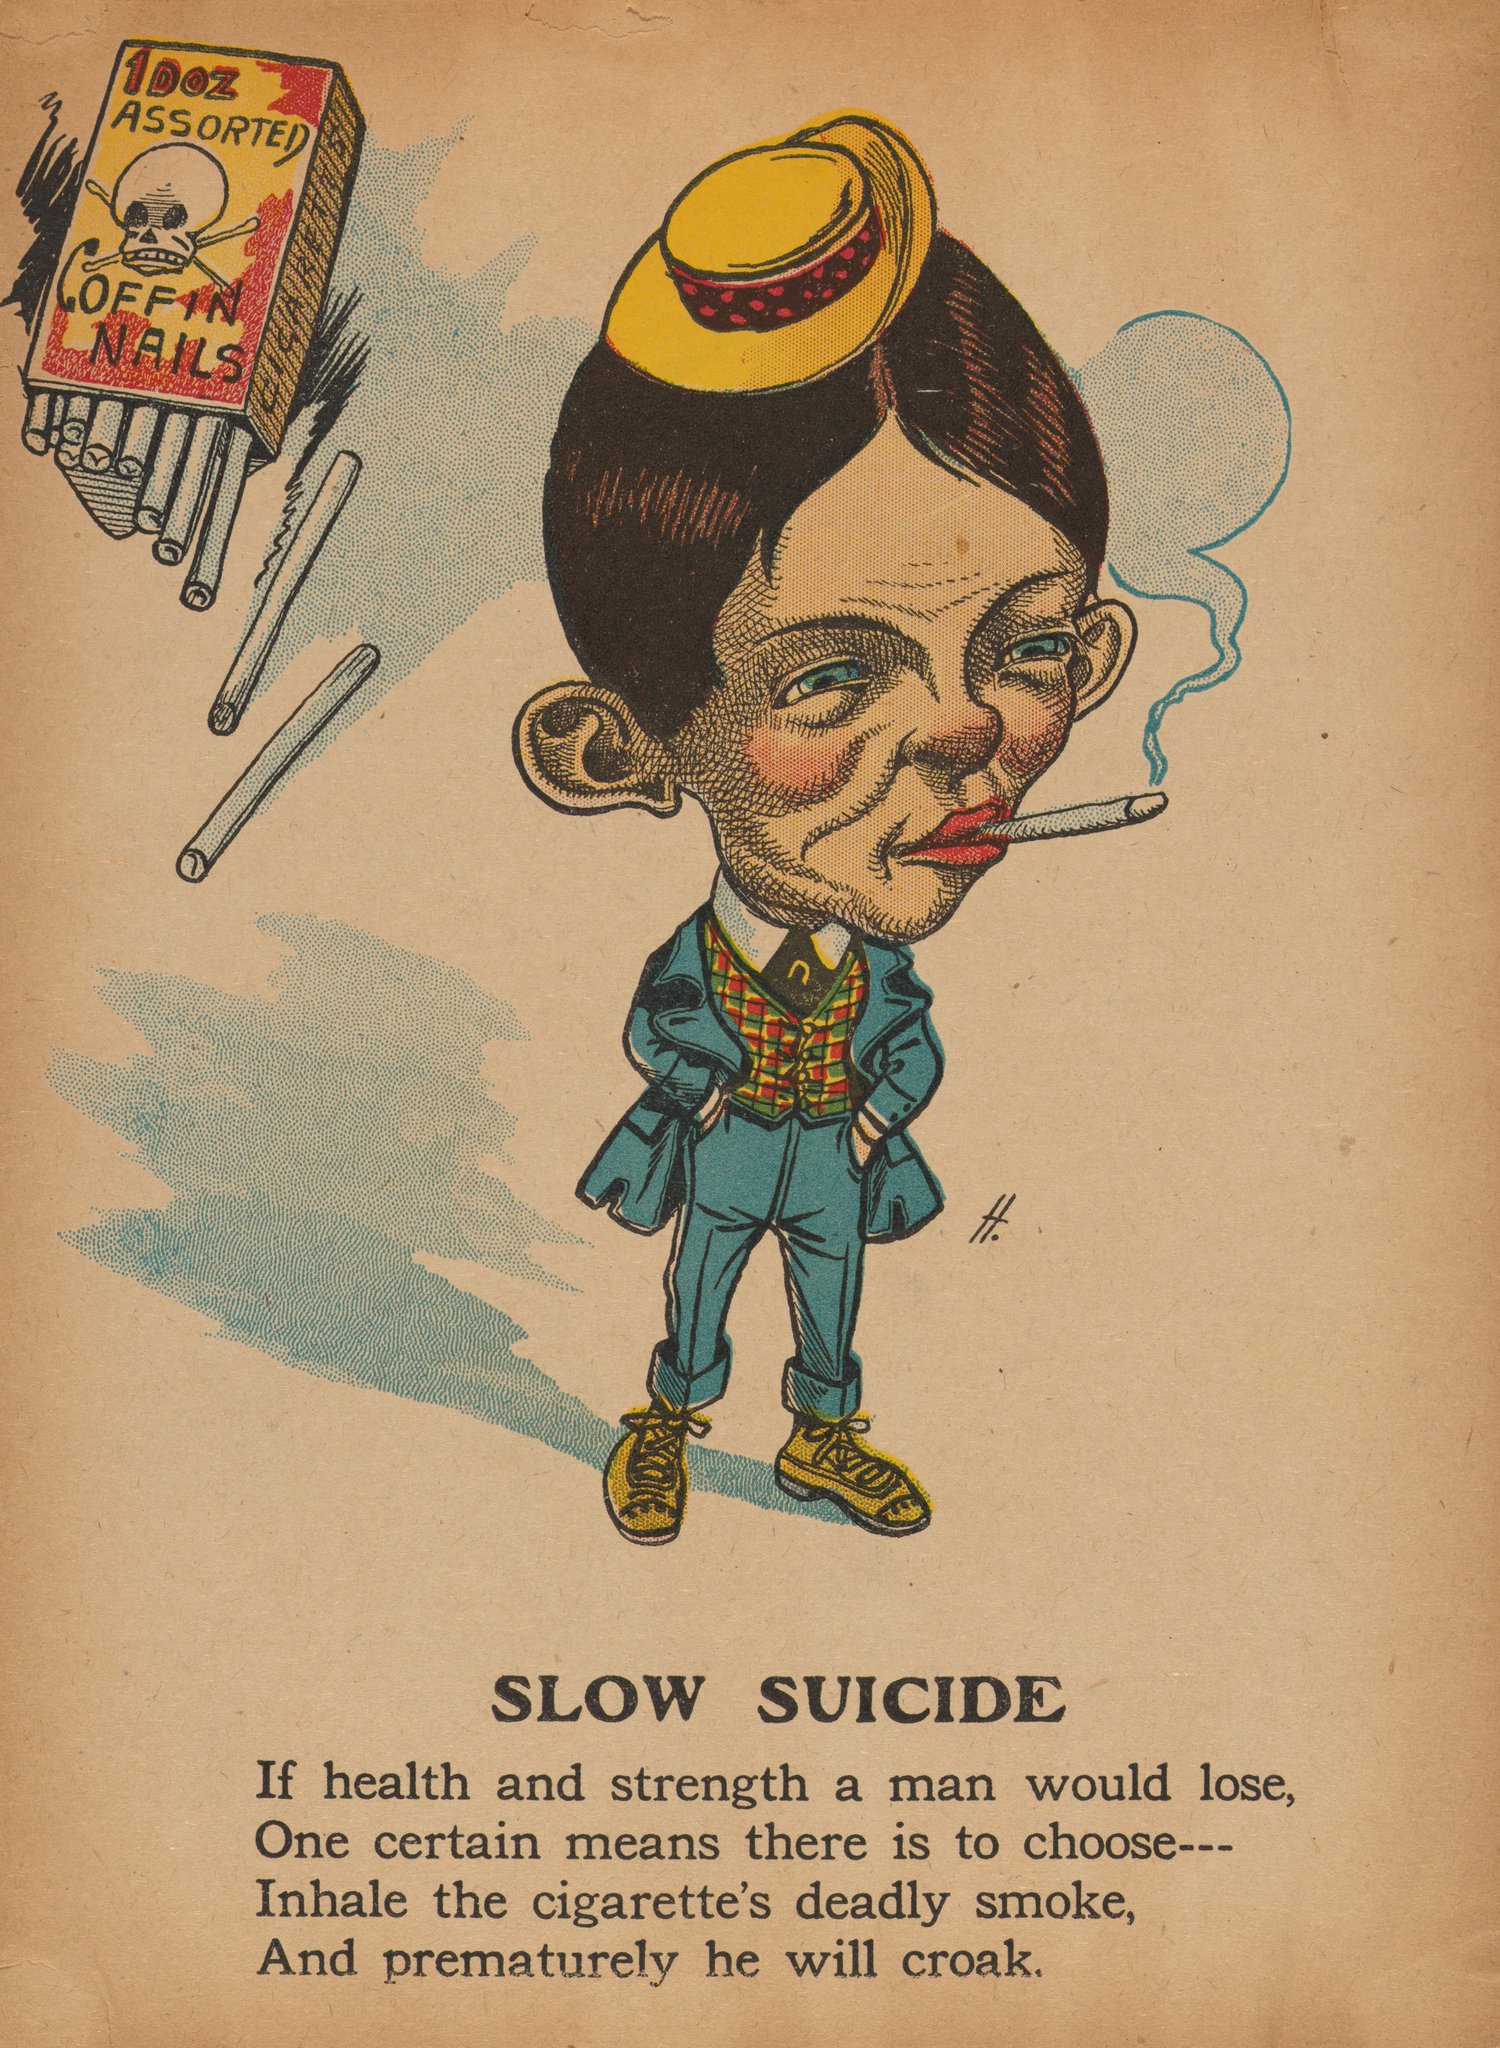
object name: valentine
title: Comic Valentine (slow suicide, anti-smoking)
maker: charles j. howard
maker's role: artist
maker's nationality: american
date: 1880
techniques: hand coloring, engraving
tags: men,smoking,cigarettes